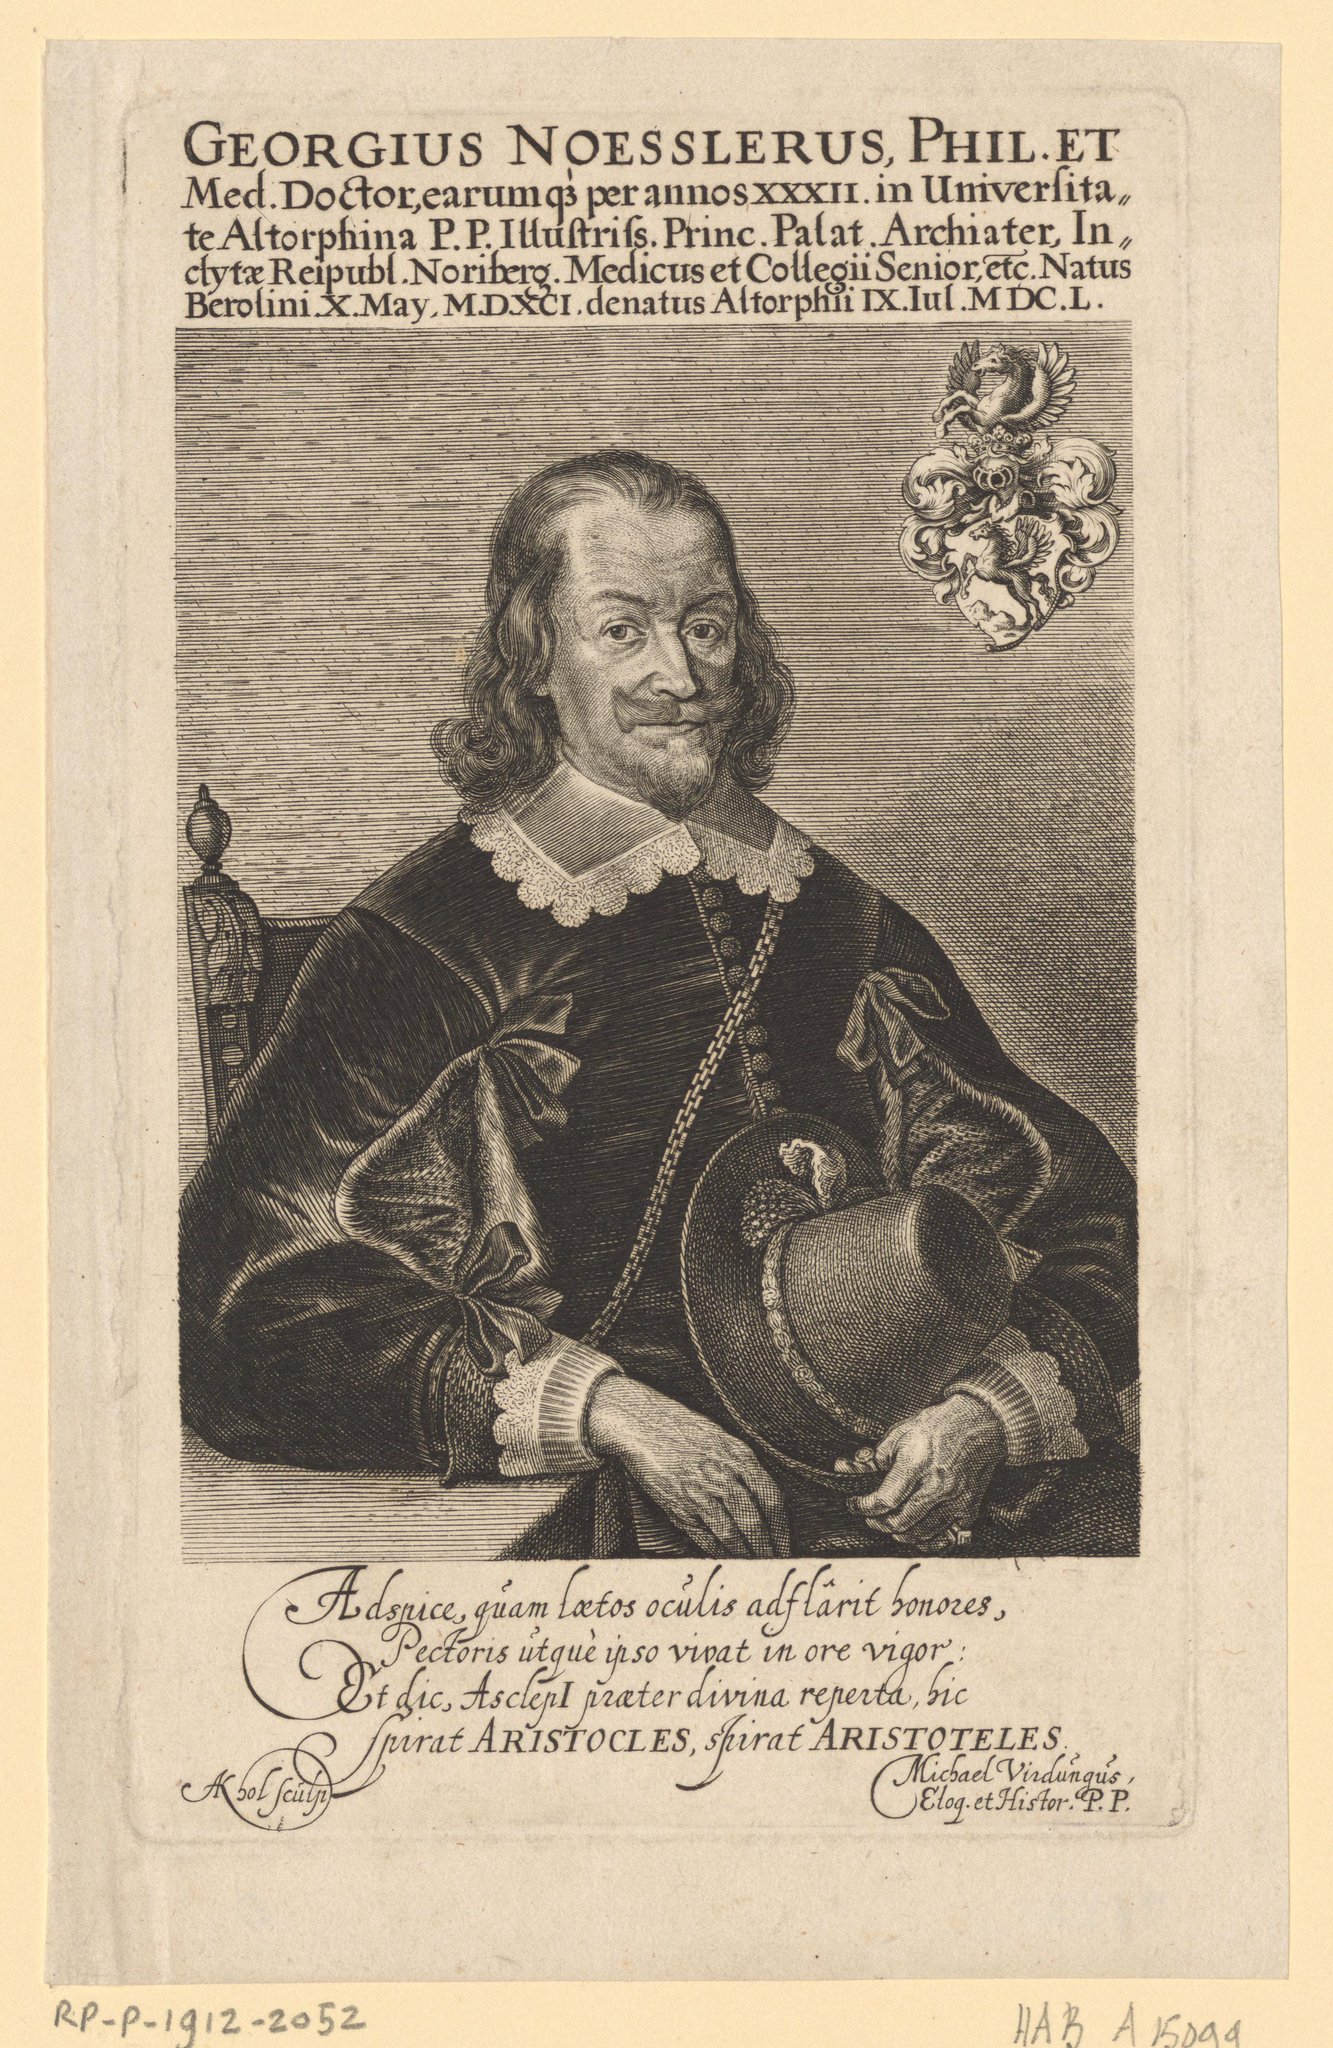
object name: print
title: Portret van Georg Nössler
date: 1650-1657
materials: paper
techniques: engraving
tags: berlin, georg nössler, historical persons, physician, doctor, armorial bearing, heraldry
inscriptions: collector's mark: Lugt 2228